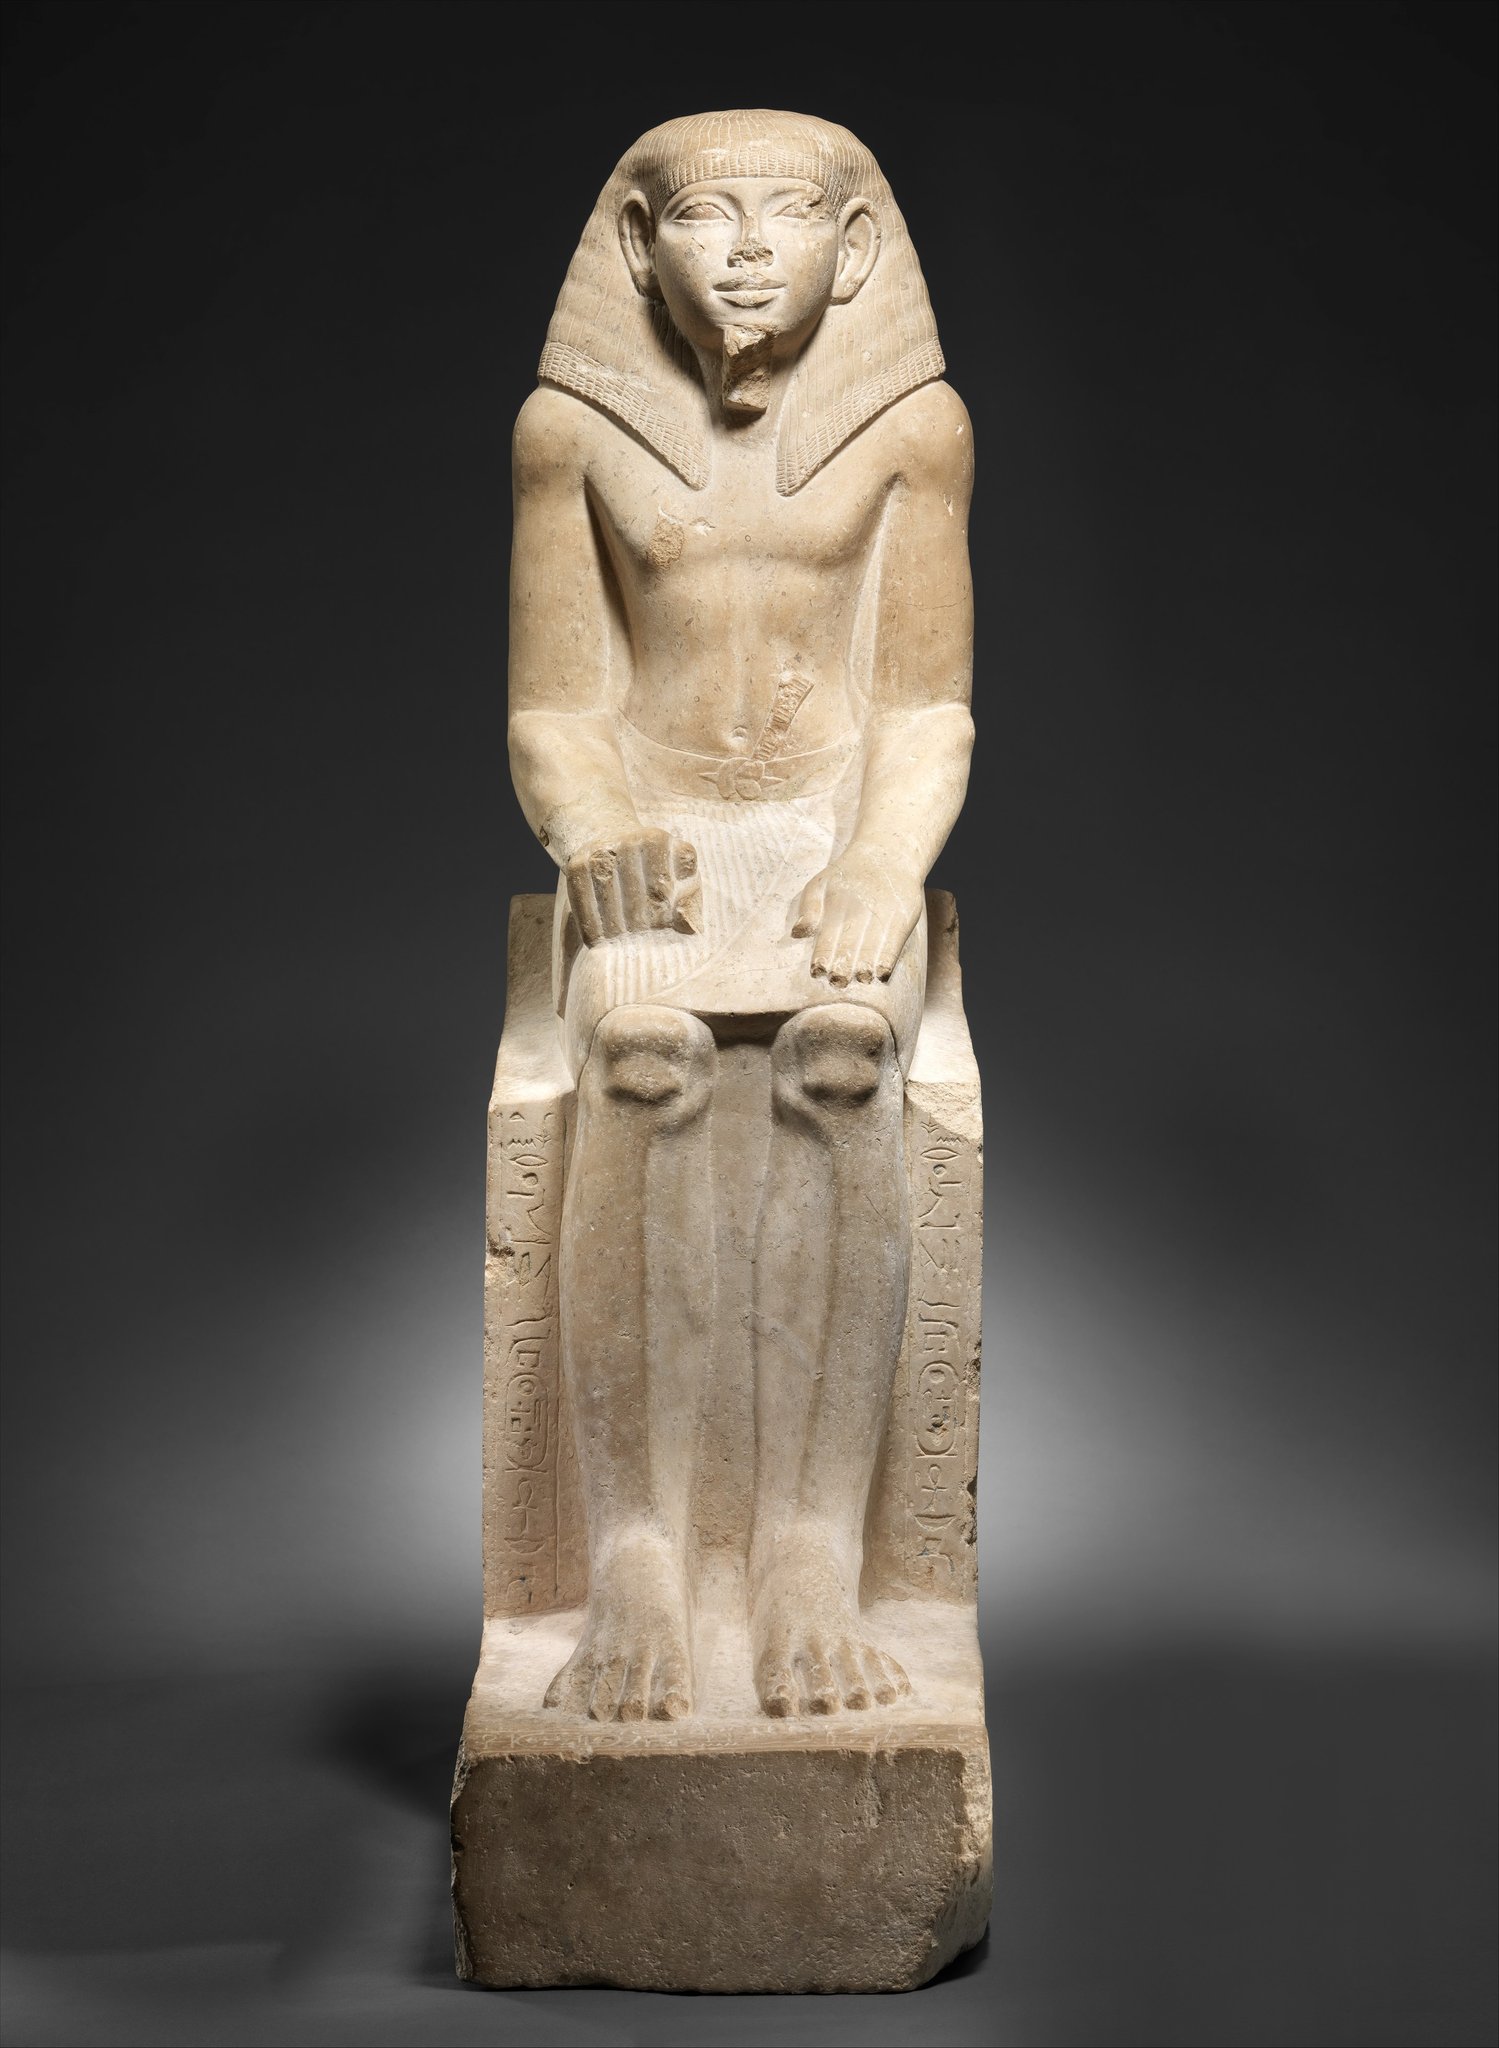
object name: statue, sehetepibreankh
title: Seated Statue of the Steward Sehetepibreankh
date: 1919-1885 BCE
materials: limestone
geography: egypt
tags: men